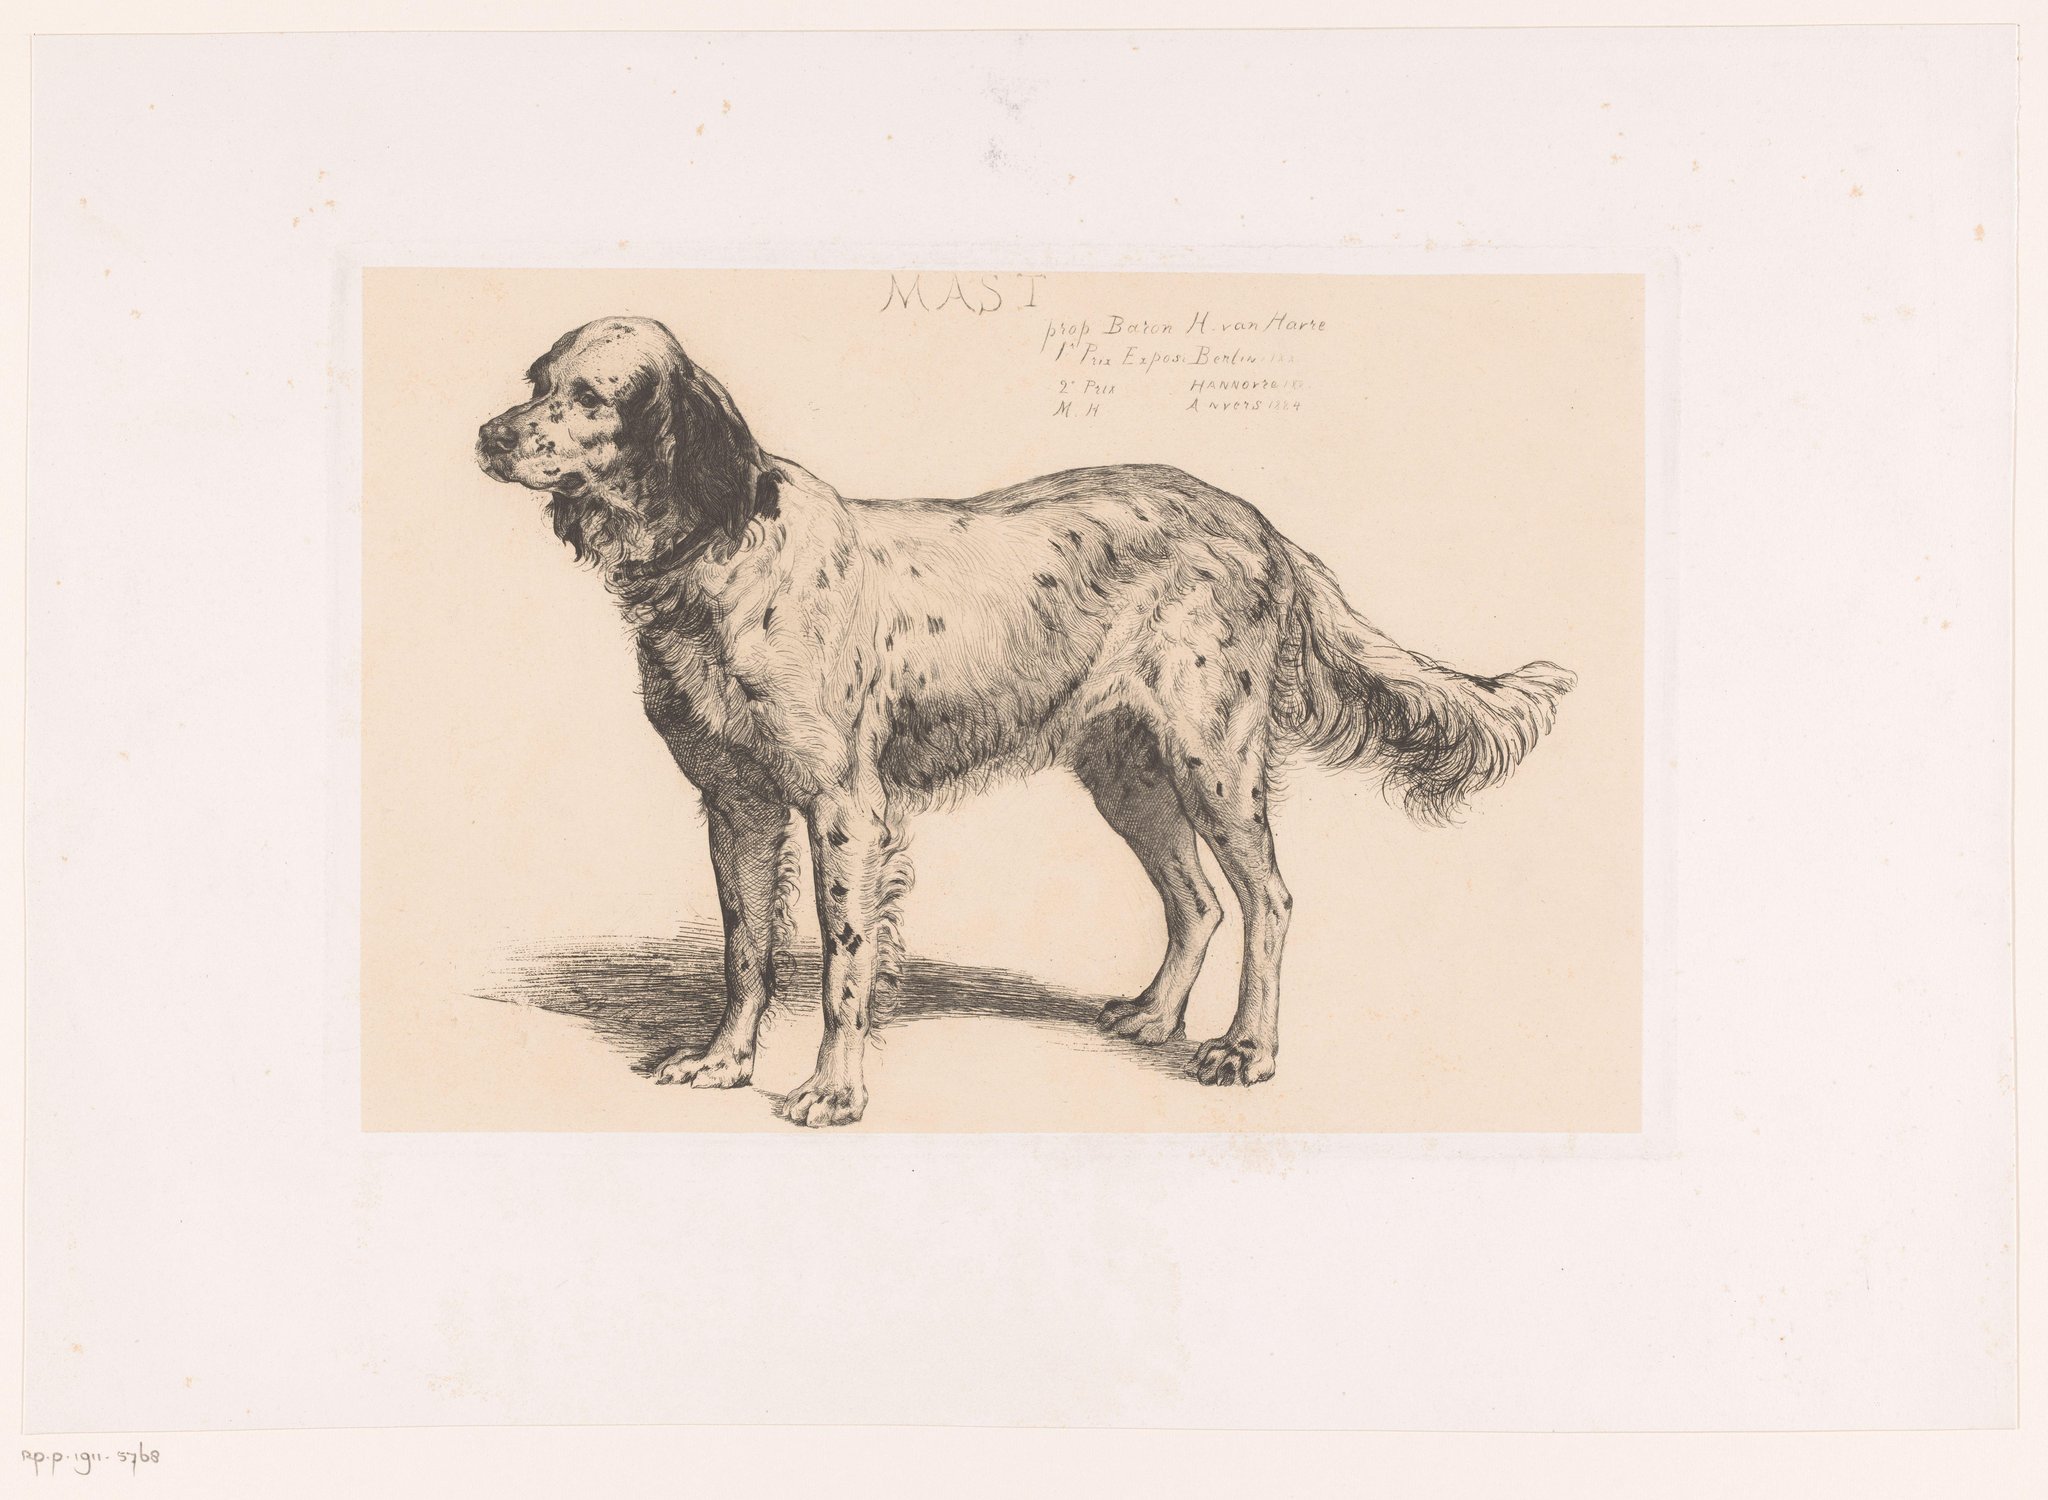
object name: print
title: Mast prop Baron H. van Havre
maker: frans lauwers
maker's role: print maker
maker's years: 1854-1931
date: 1884-1911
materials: paper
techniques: etching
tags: dog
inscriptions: collector's mark: Lugt 2228